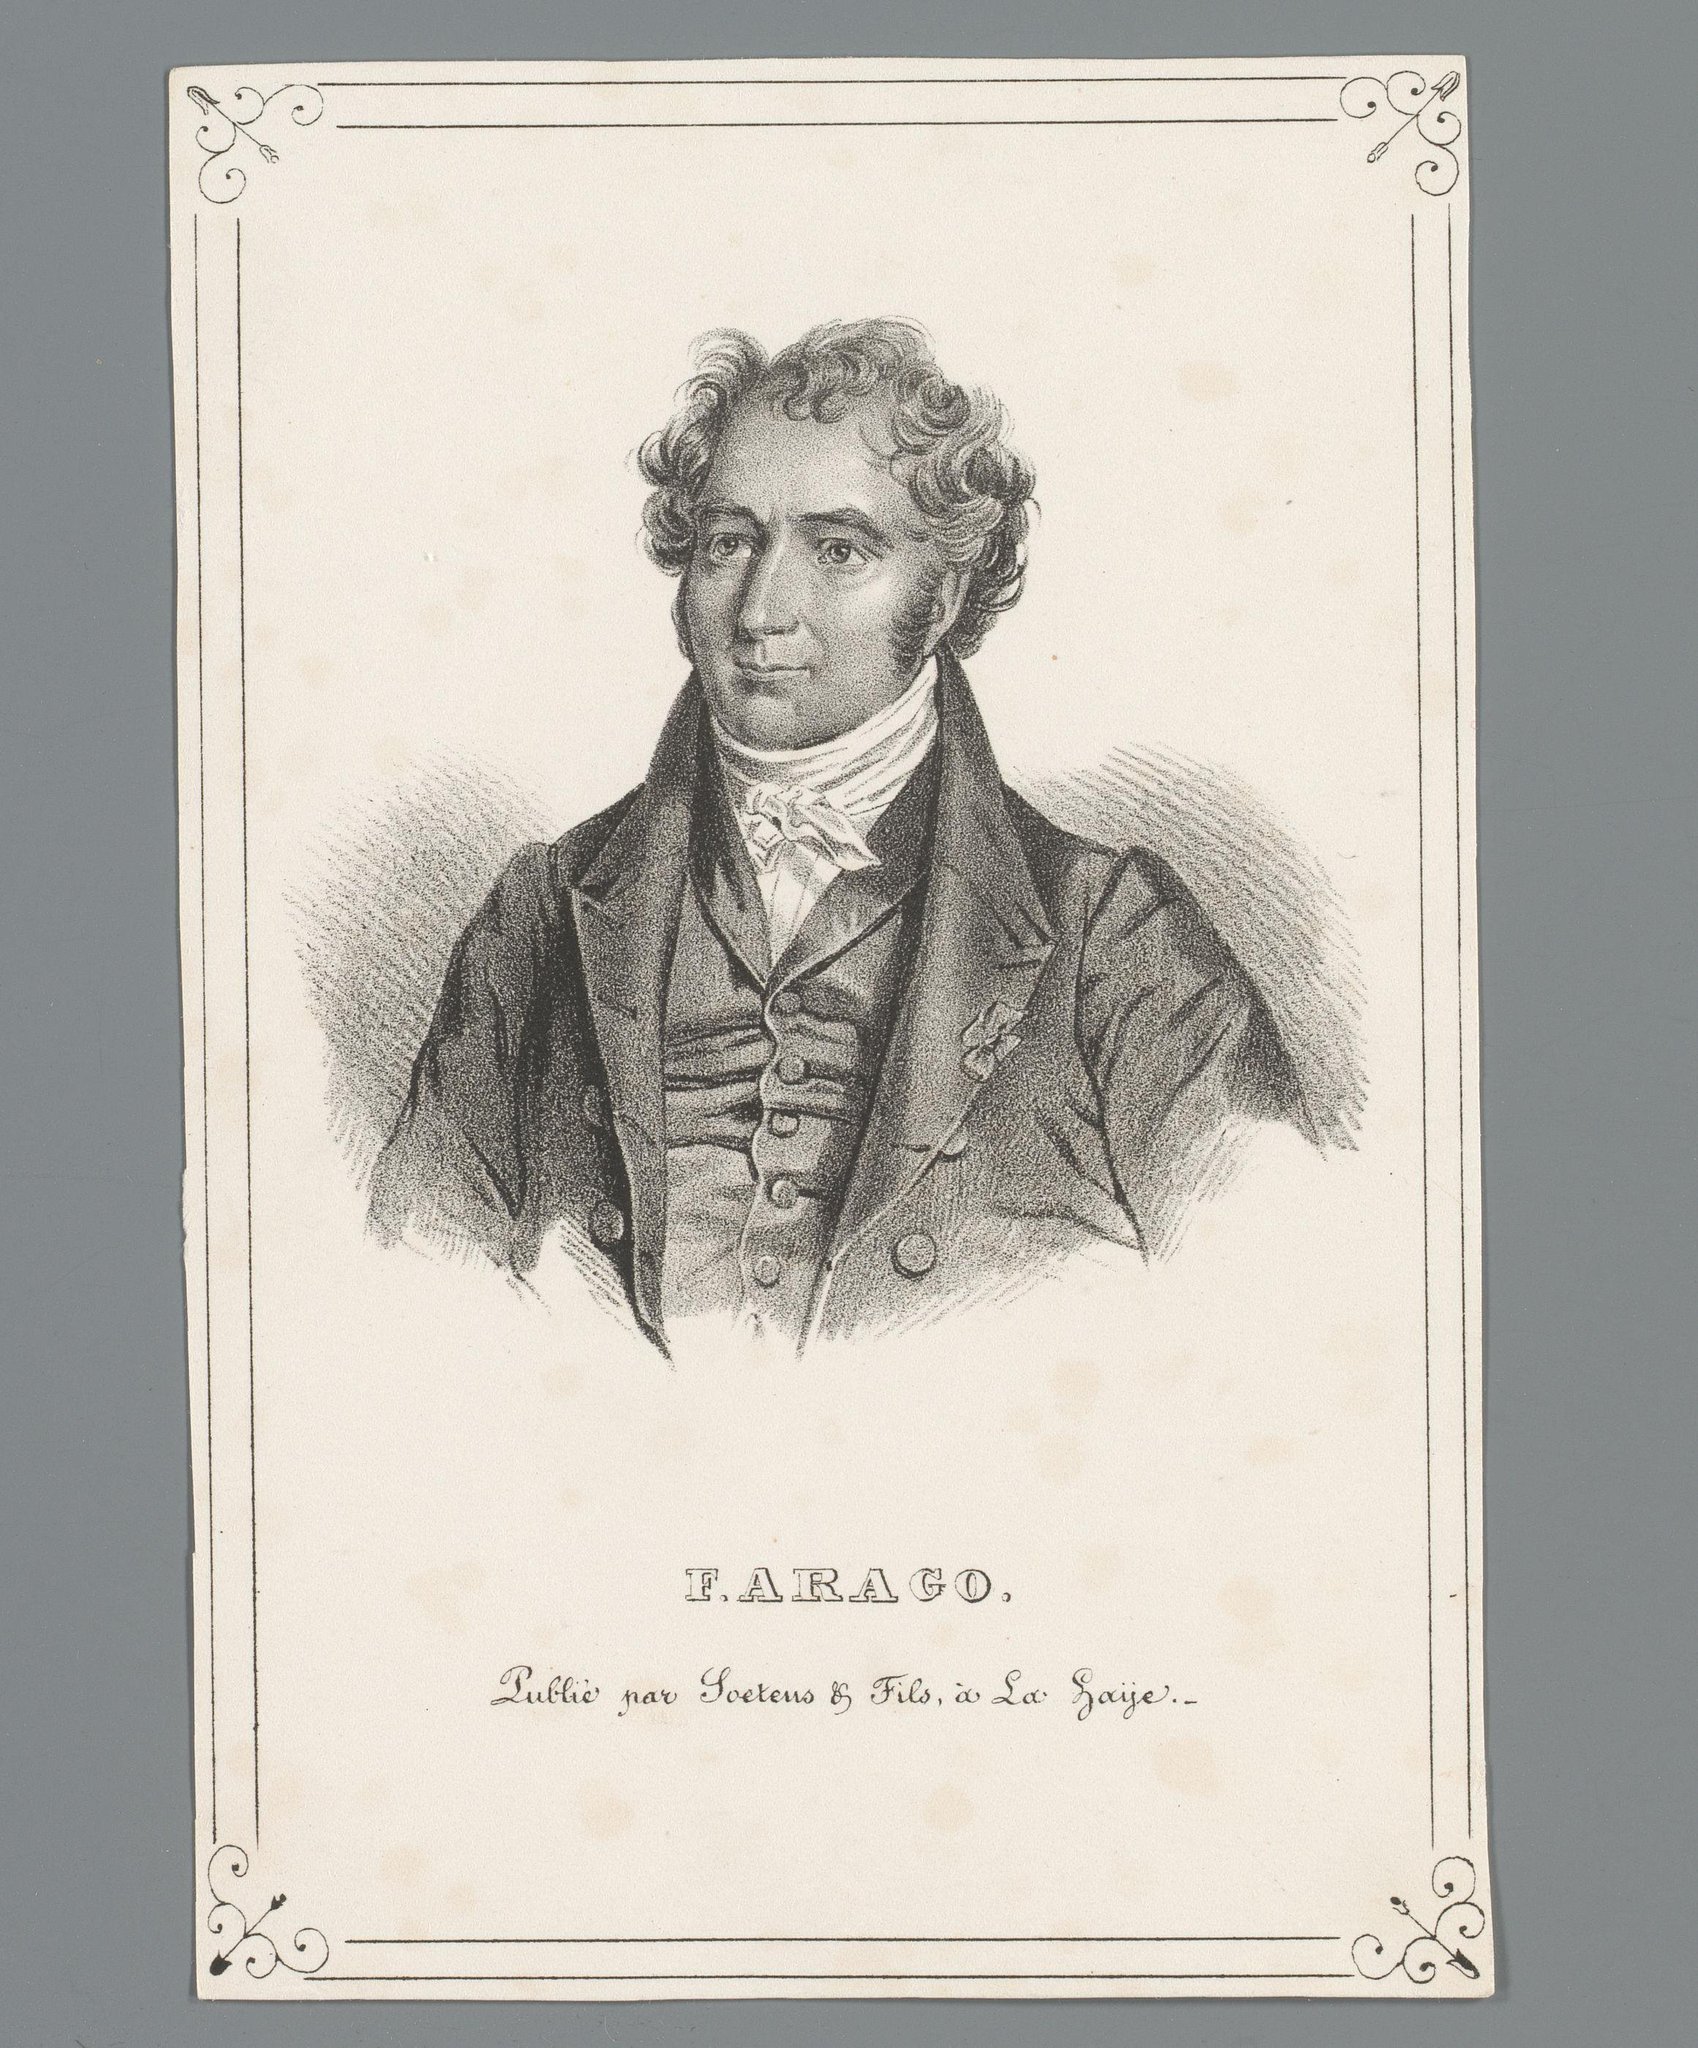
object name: print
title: Portret van François Arago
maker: wilhelmus cornelis chimaer van oudendorp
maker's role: print maker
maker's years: 1822-1873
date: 1837-1840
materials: paper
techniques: lithograph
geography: netherlands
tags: paris, historical persons